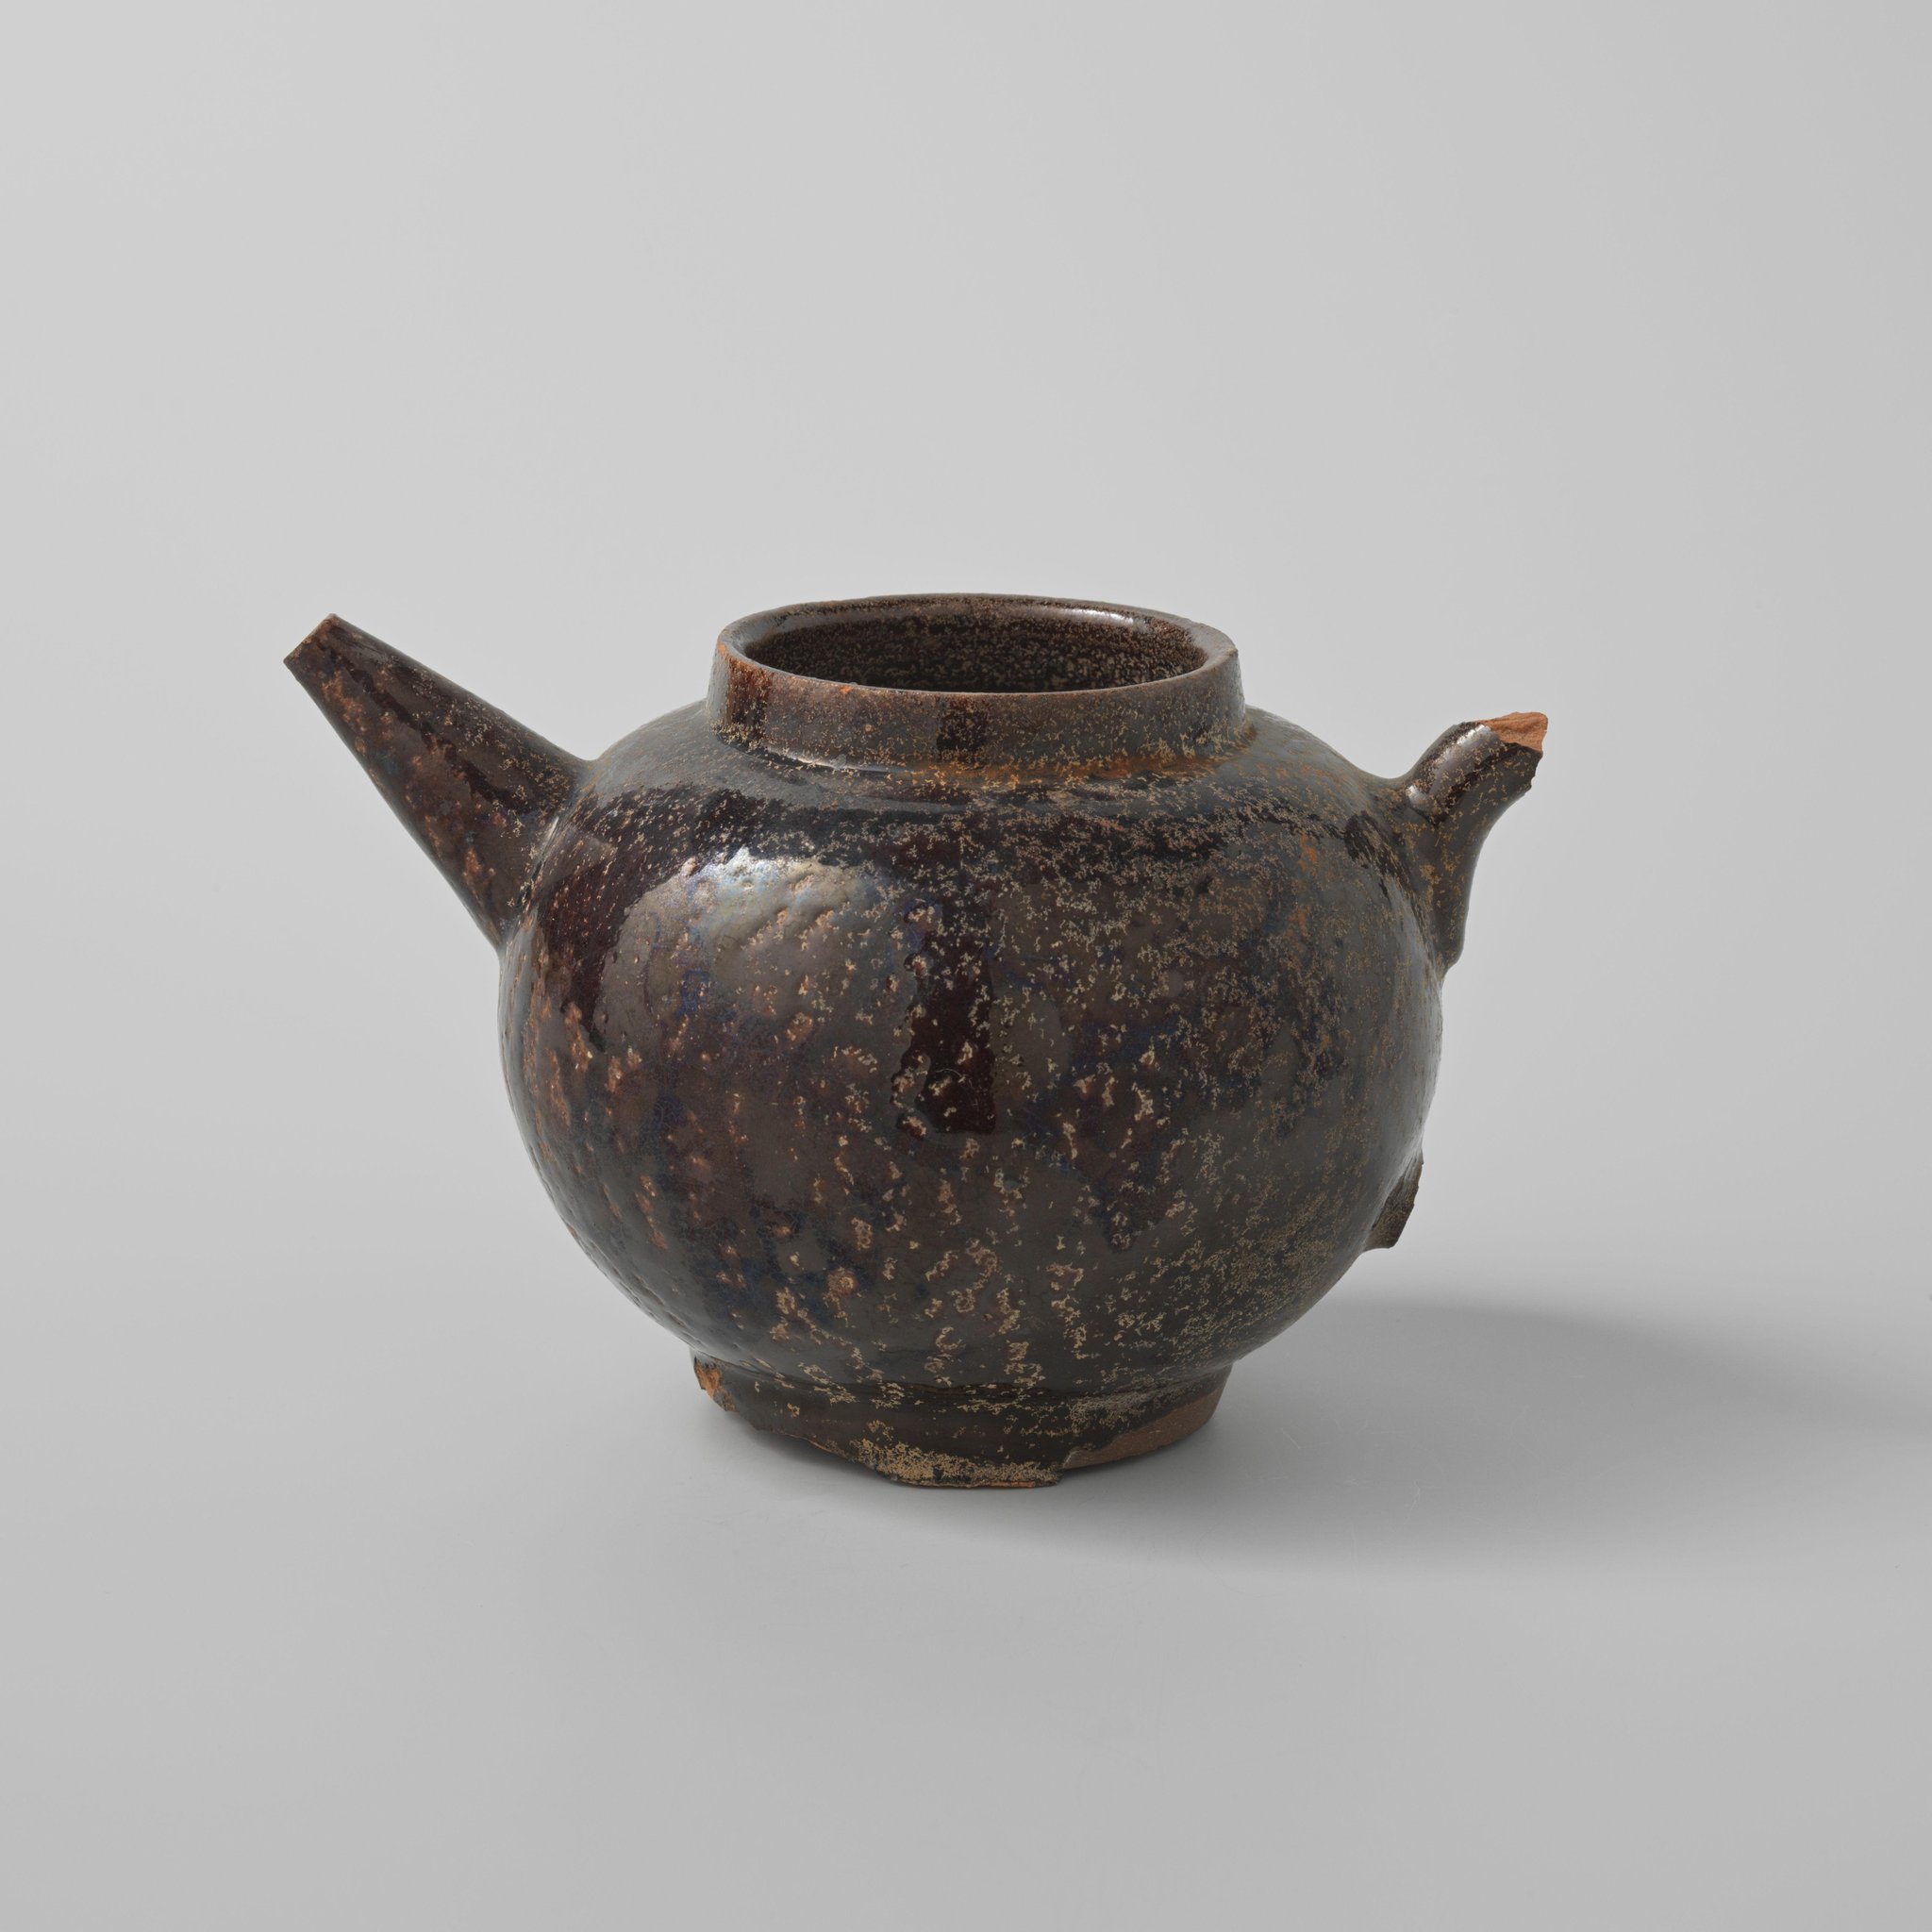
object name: fragment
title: Theepot met een zwart geïriseerd glazuur (De Caluwe bakafval)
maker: jacobus de caluwe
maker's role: plateelbakkerij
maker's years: -1730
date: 1700-1725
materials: earthenware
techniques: firing, vitrification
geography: delft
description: Toegeschreven aan Jacobus de Caluwe, omdat dit voorwerp samen met gemerkte stukken (‘Jacobus De Caluwe’ en rennend hert) gevonden is op de plaats waar zich De Caluwes tweede werkplaats bevond. Er is een duidelijke stilistische overeenkomst tussen de gemerkte en niet gemerkte voorwerpen uit deze archeologische vondst.